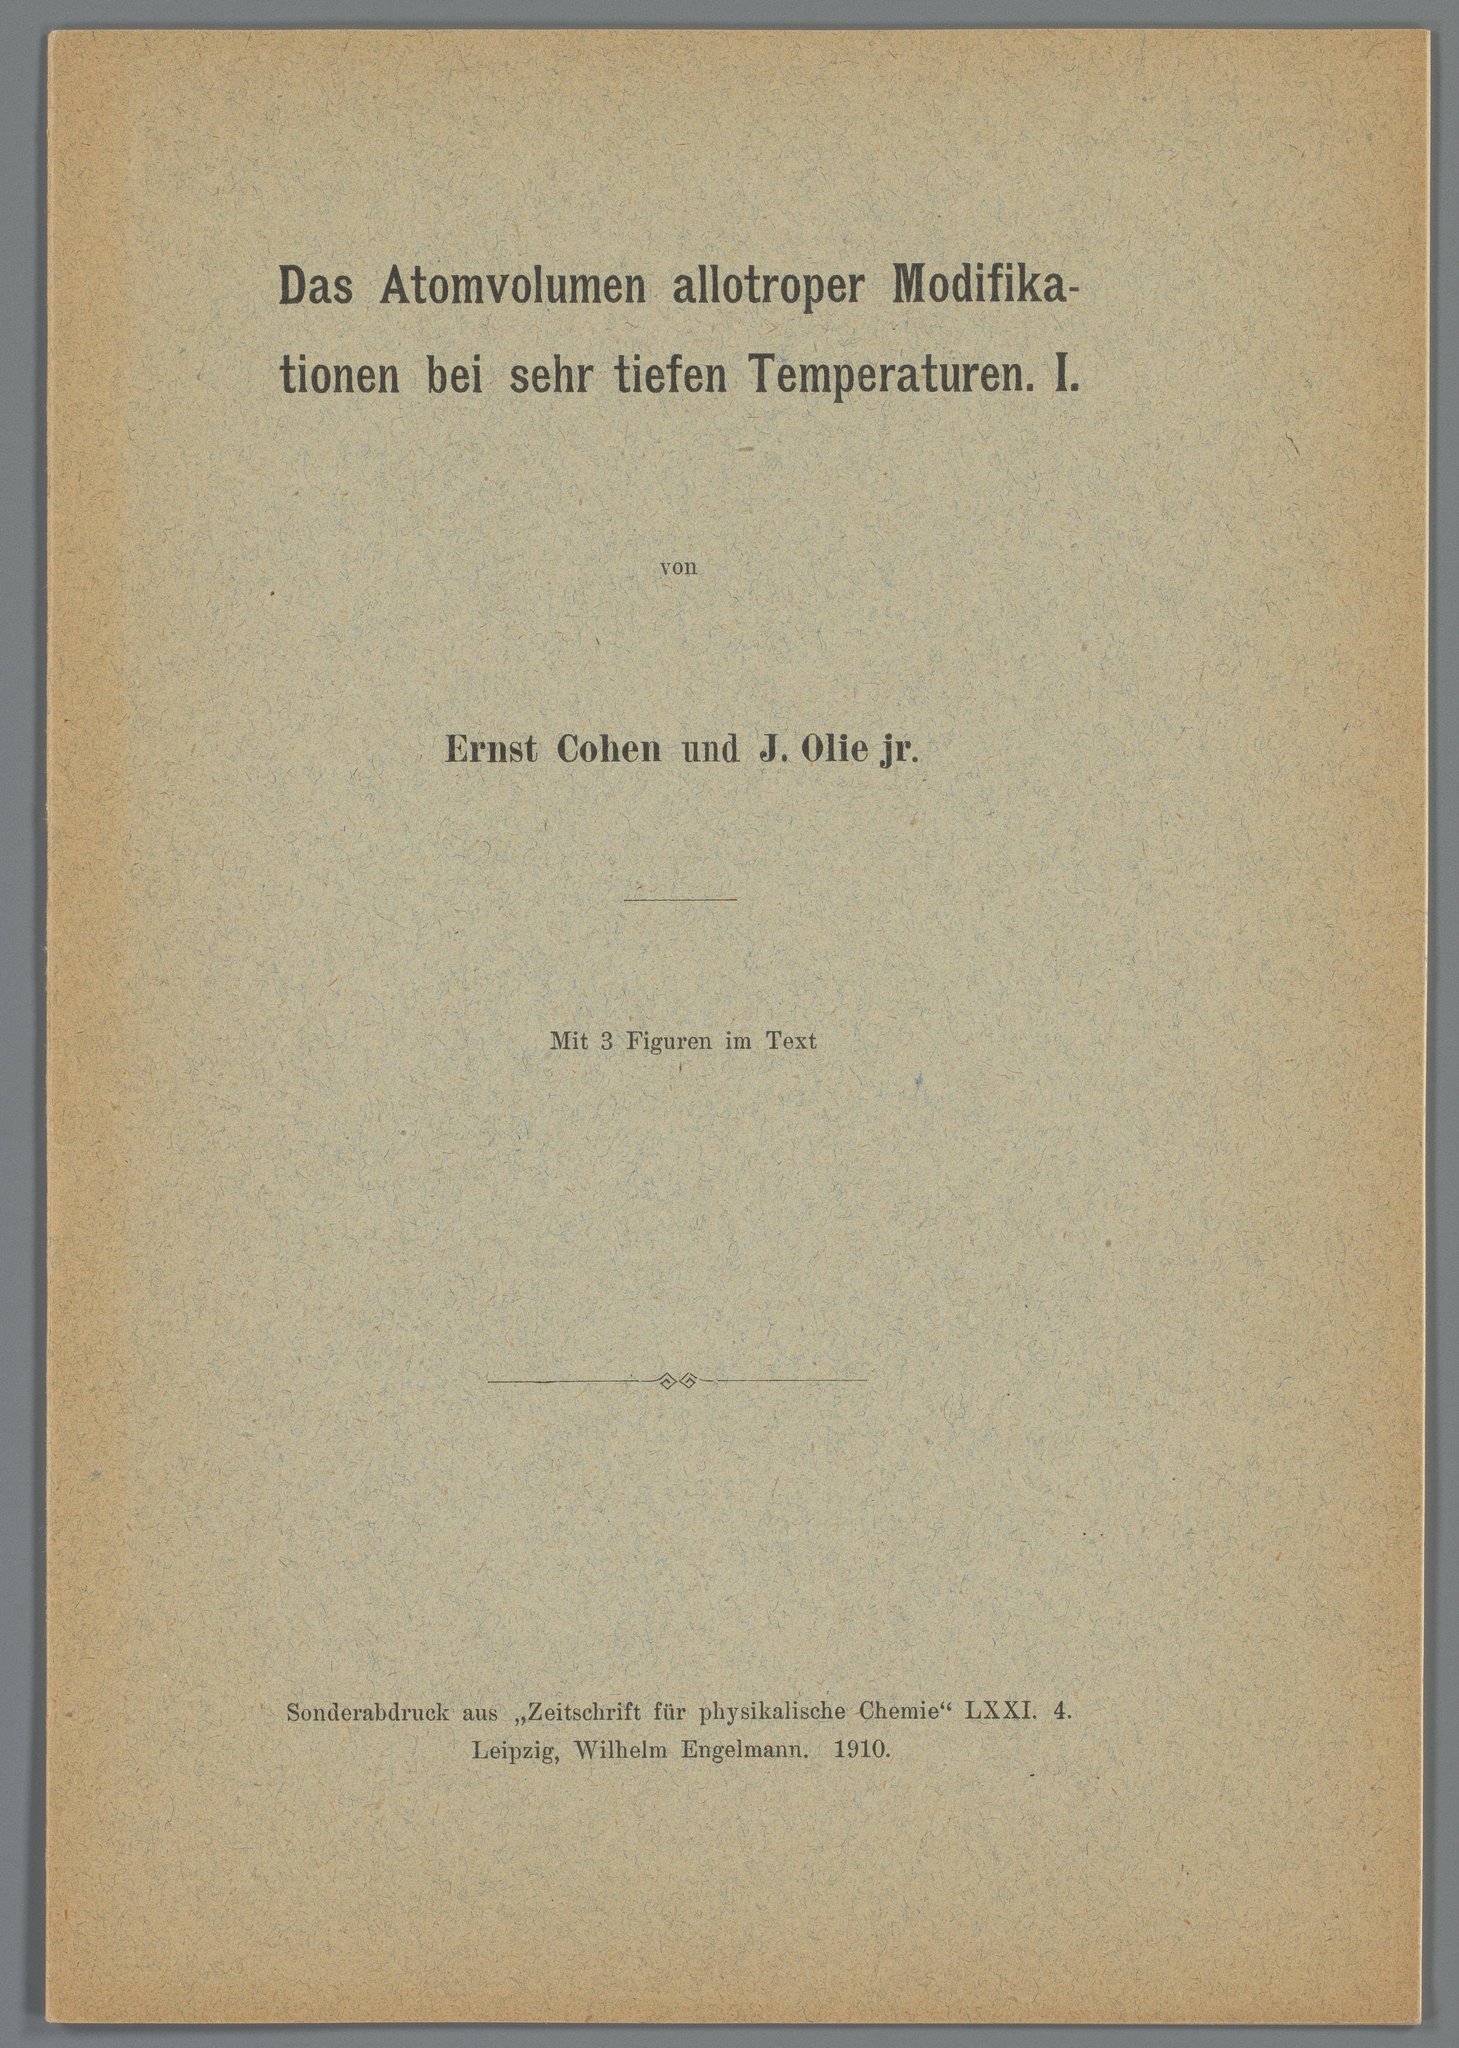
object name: offprint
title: Das Atomvolumen allotroper Modifikationen bei sehr tiefen Temperaturen. I.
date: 1910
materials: paper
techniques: letterpress printing, printing block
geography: leipzig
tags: printed matter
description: Overdruk uit het Zeitschrift für physikalische Chemie LXXI 4, 1910.